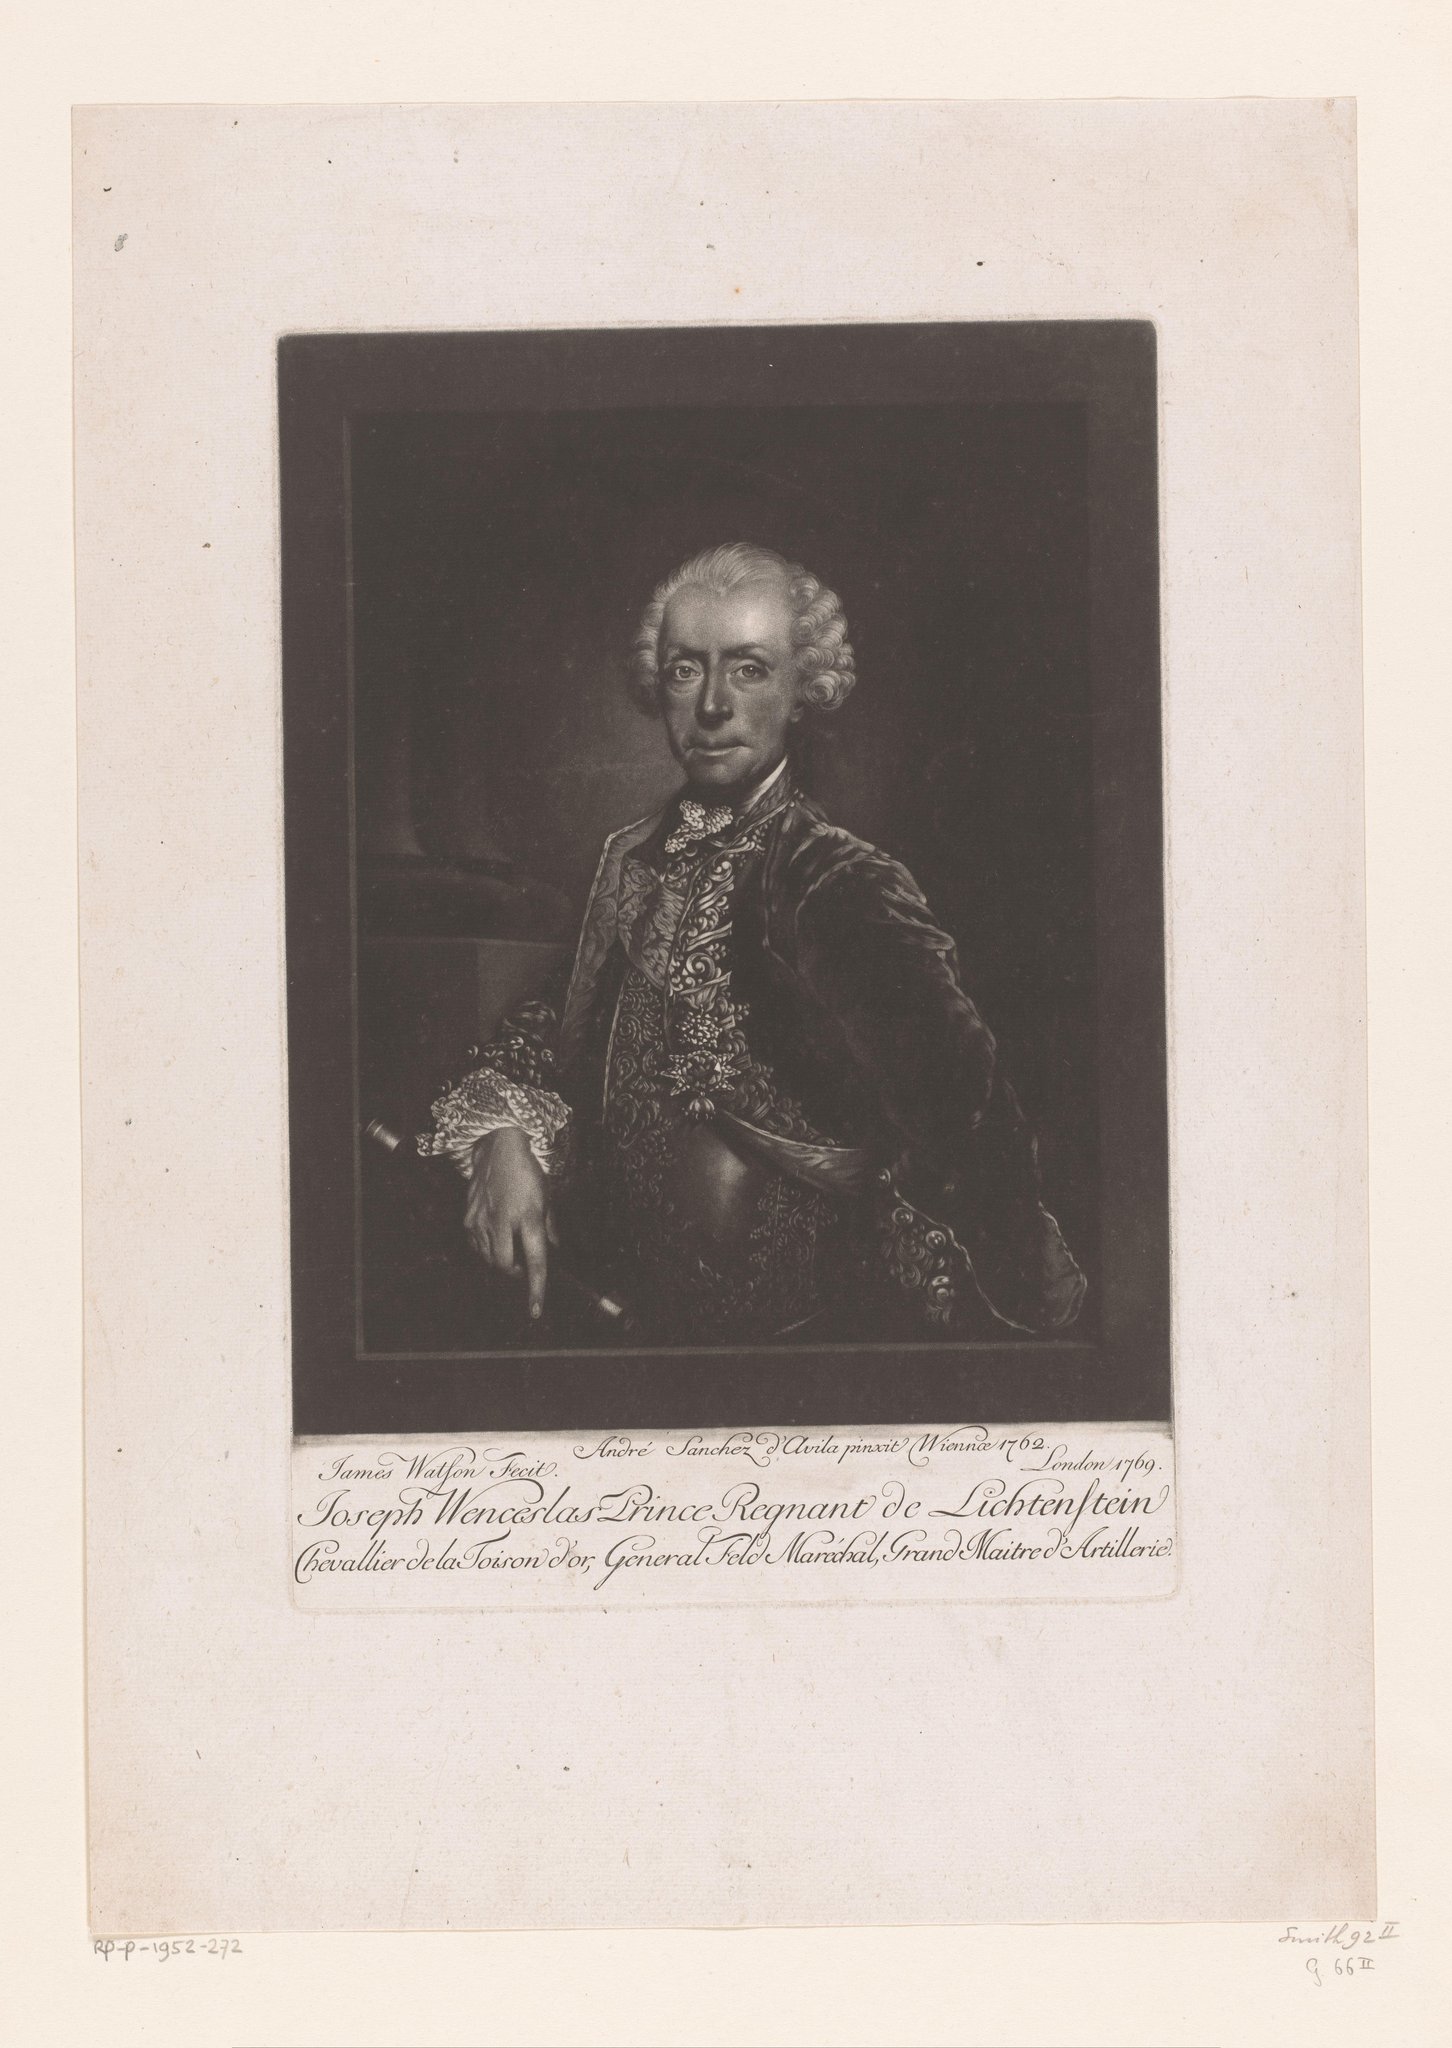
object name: print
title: Joseph Wenceslas Prince Regnant de Lichtenstein (...)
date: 1769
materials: paper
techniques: mezzotint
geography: london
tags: historical persons, ruler, sovereign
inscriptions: collector's mark: Lugt 2228